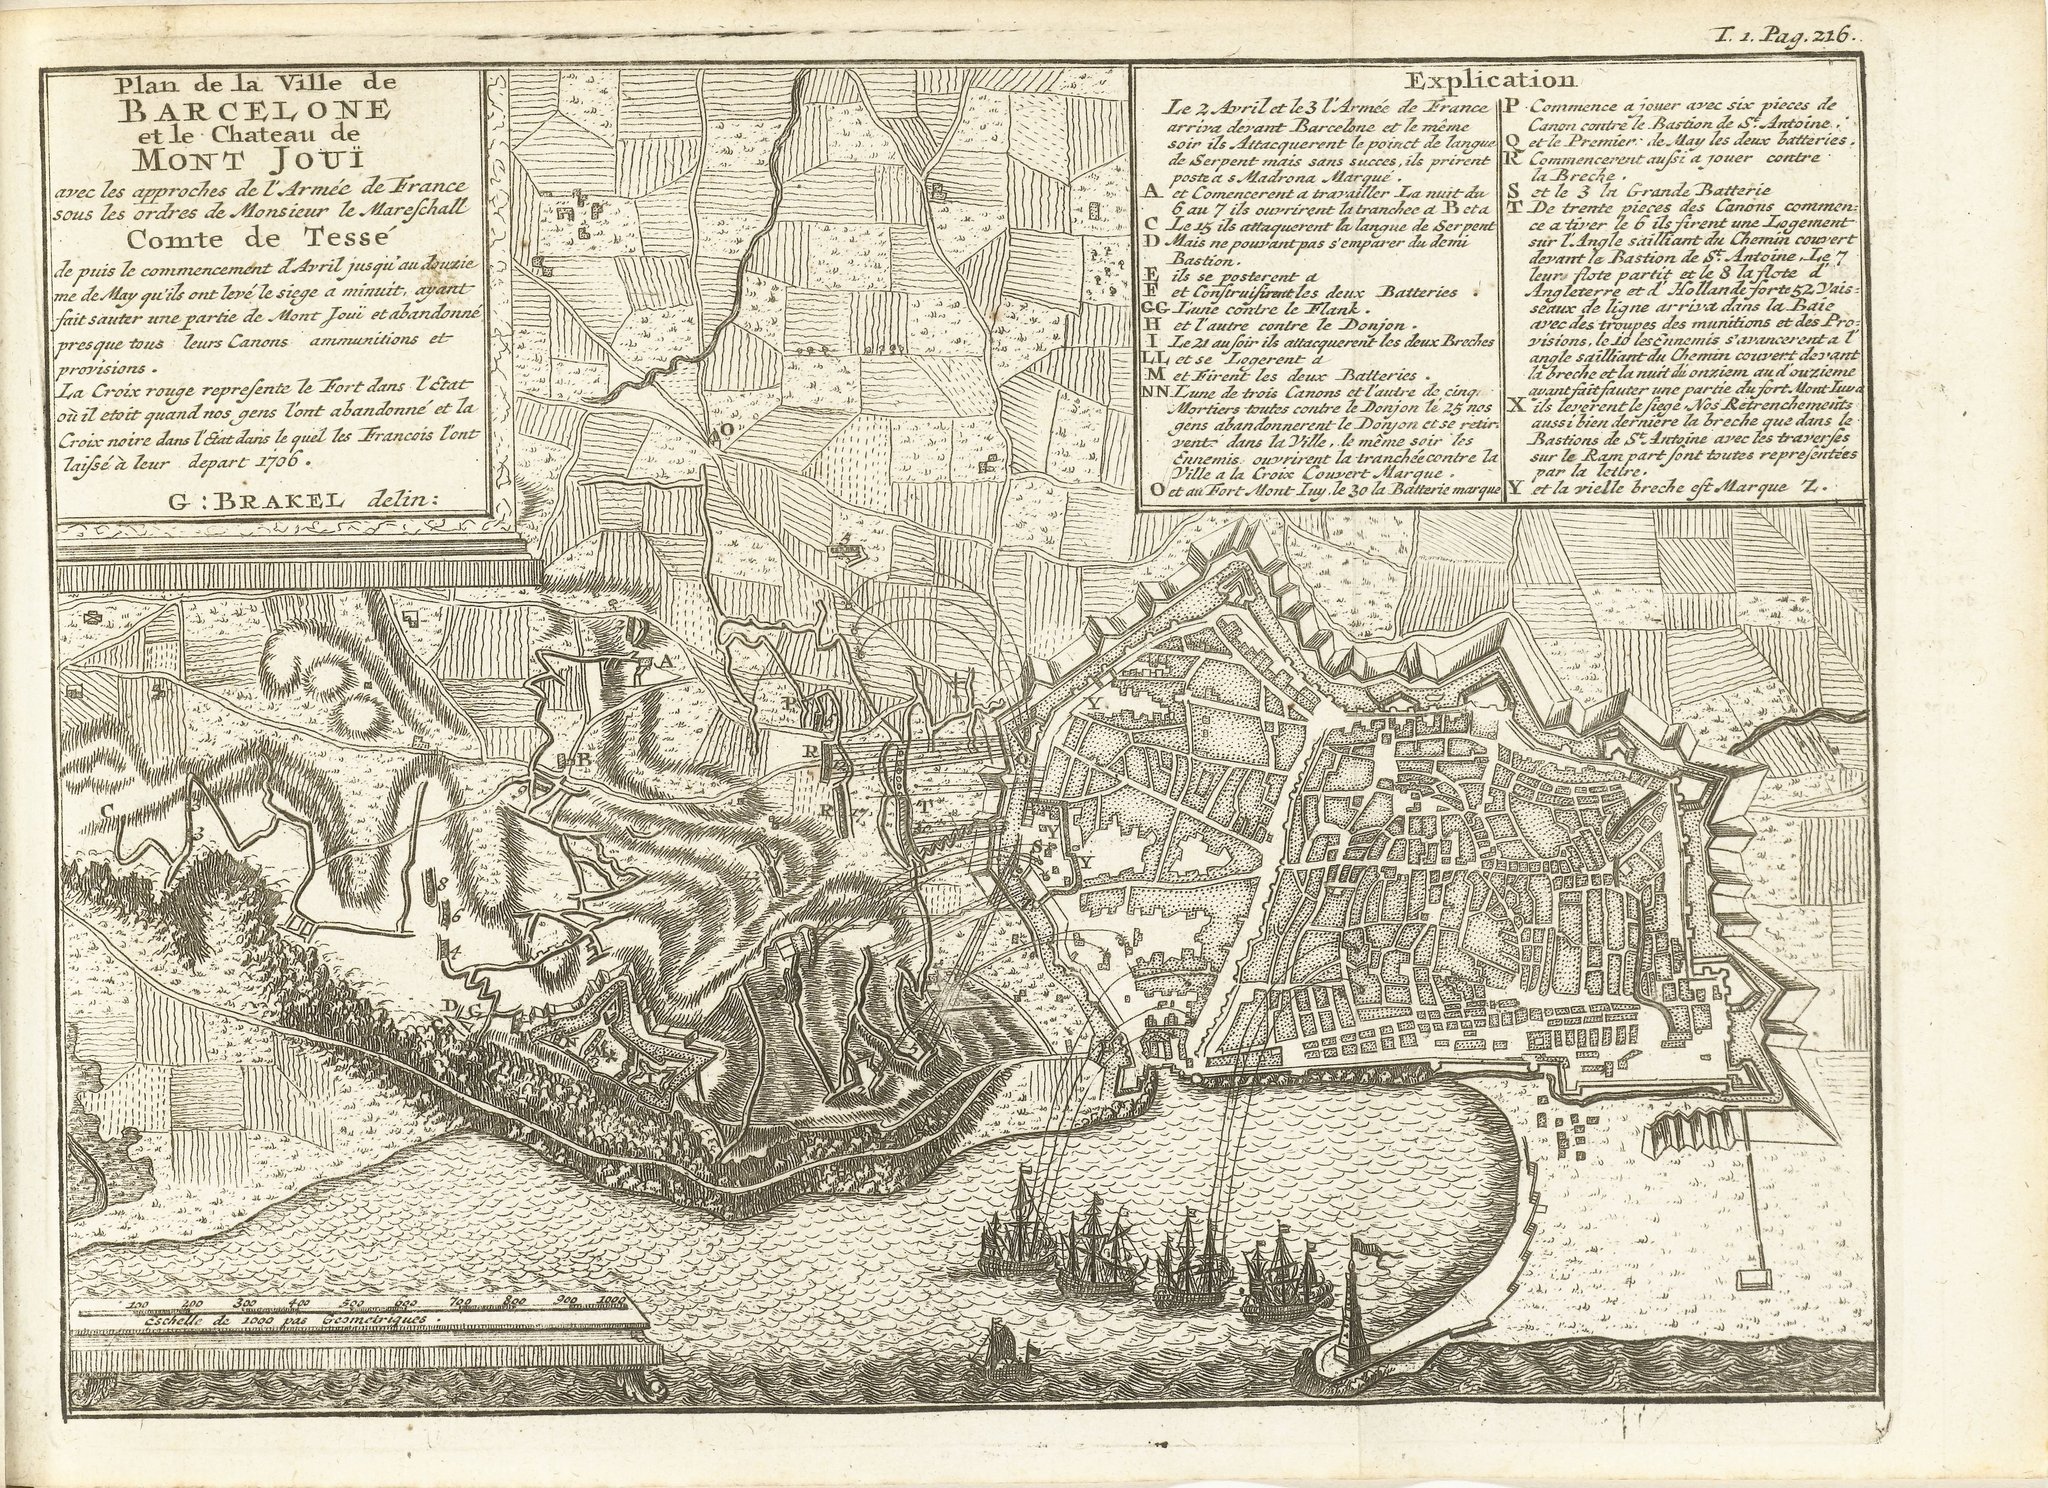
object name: map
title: Beleg van Barcelona, 1706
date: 1714-1716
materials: paper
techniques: etching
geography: amsterdam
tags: johan willem friso (prins van oranje-nassau), siege, position war, maps of cities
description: Kaart van Barcelona belegerd door het Franse leger en ontzet door de geallieerden, 12 Mei 1706. Illustratie in de Nederlandse vertaling uit 1716 van J. Lamigue, Het leven van Zyne Hoogheit Johan Willem Friso, dl. I, p. 216/217.